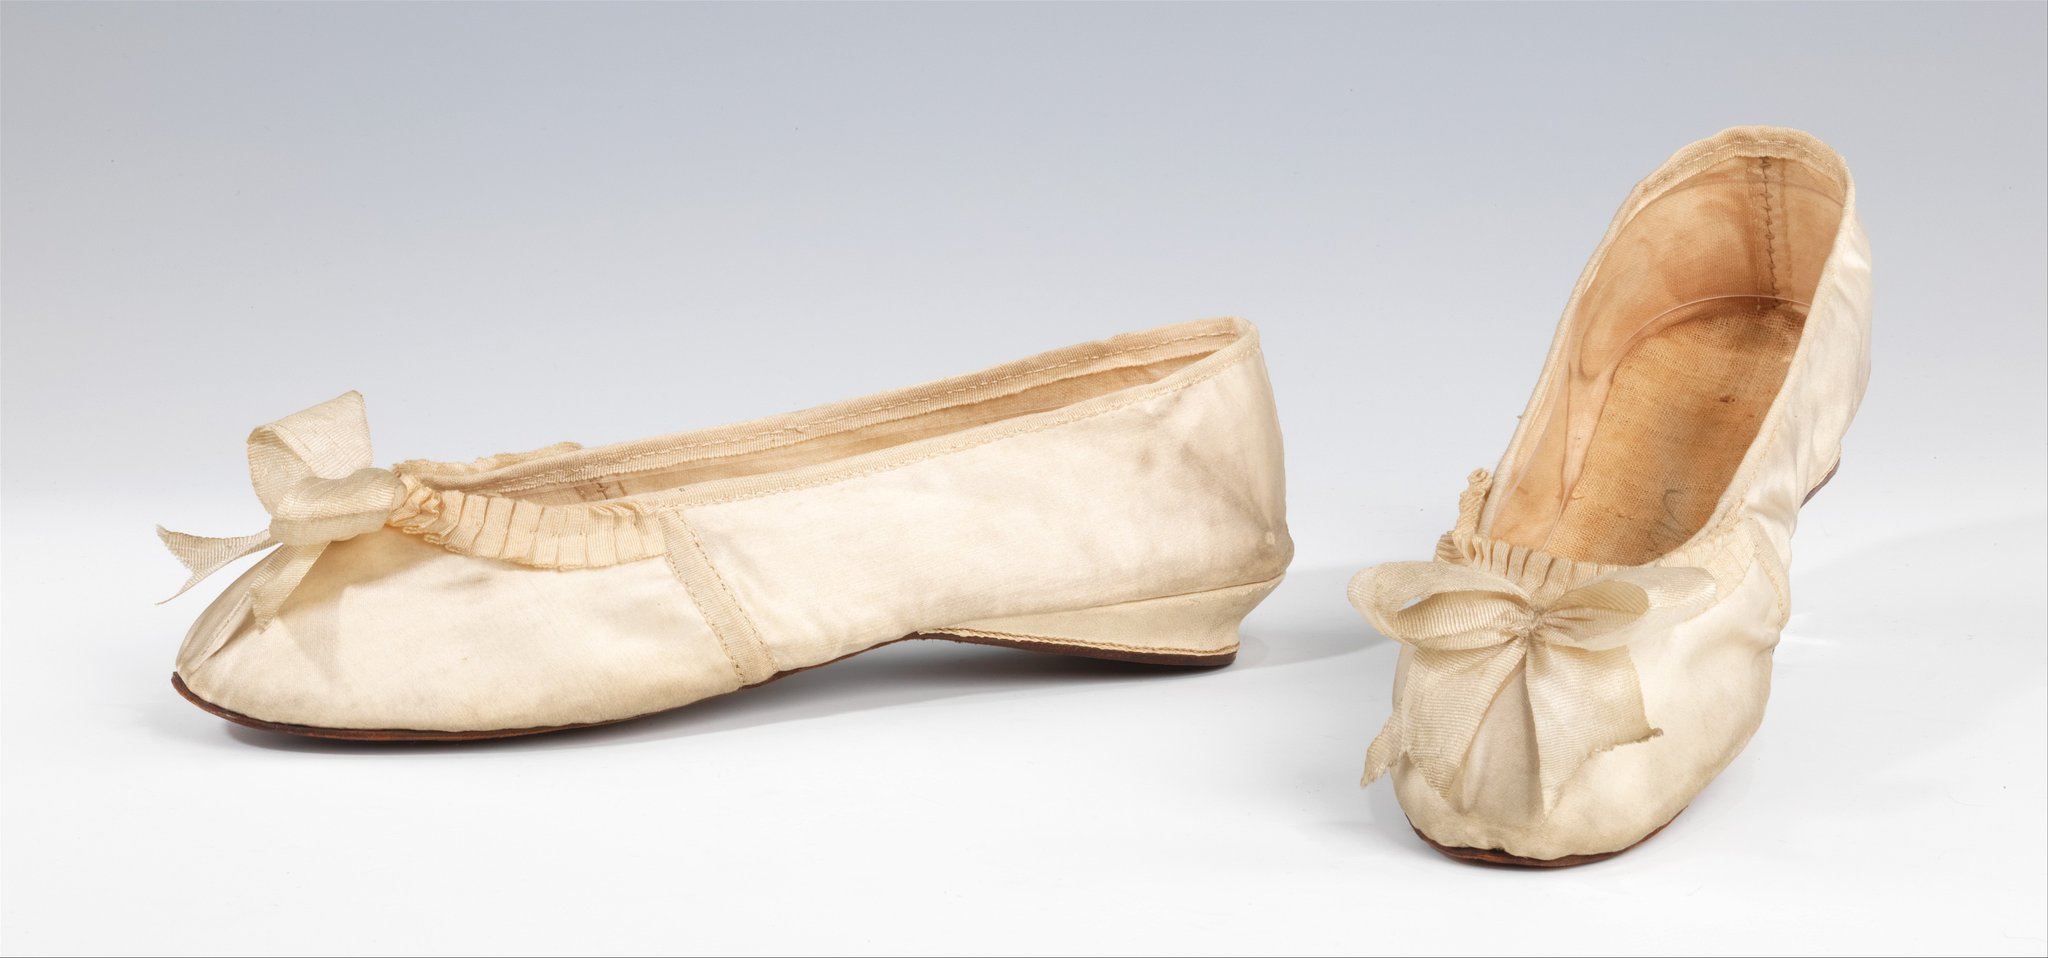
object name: evening slipper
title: Evening slippers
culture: european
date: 1805-1815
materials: silk